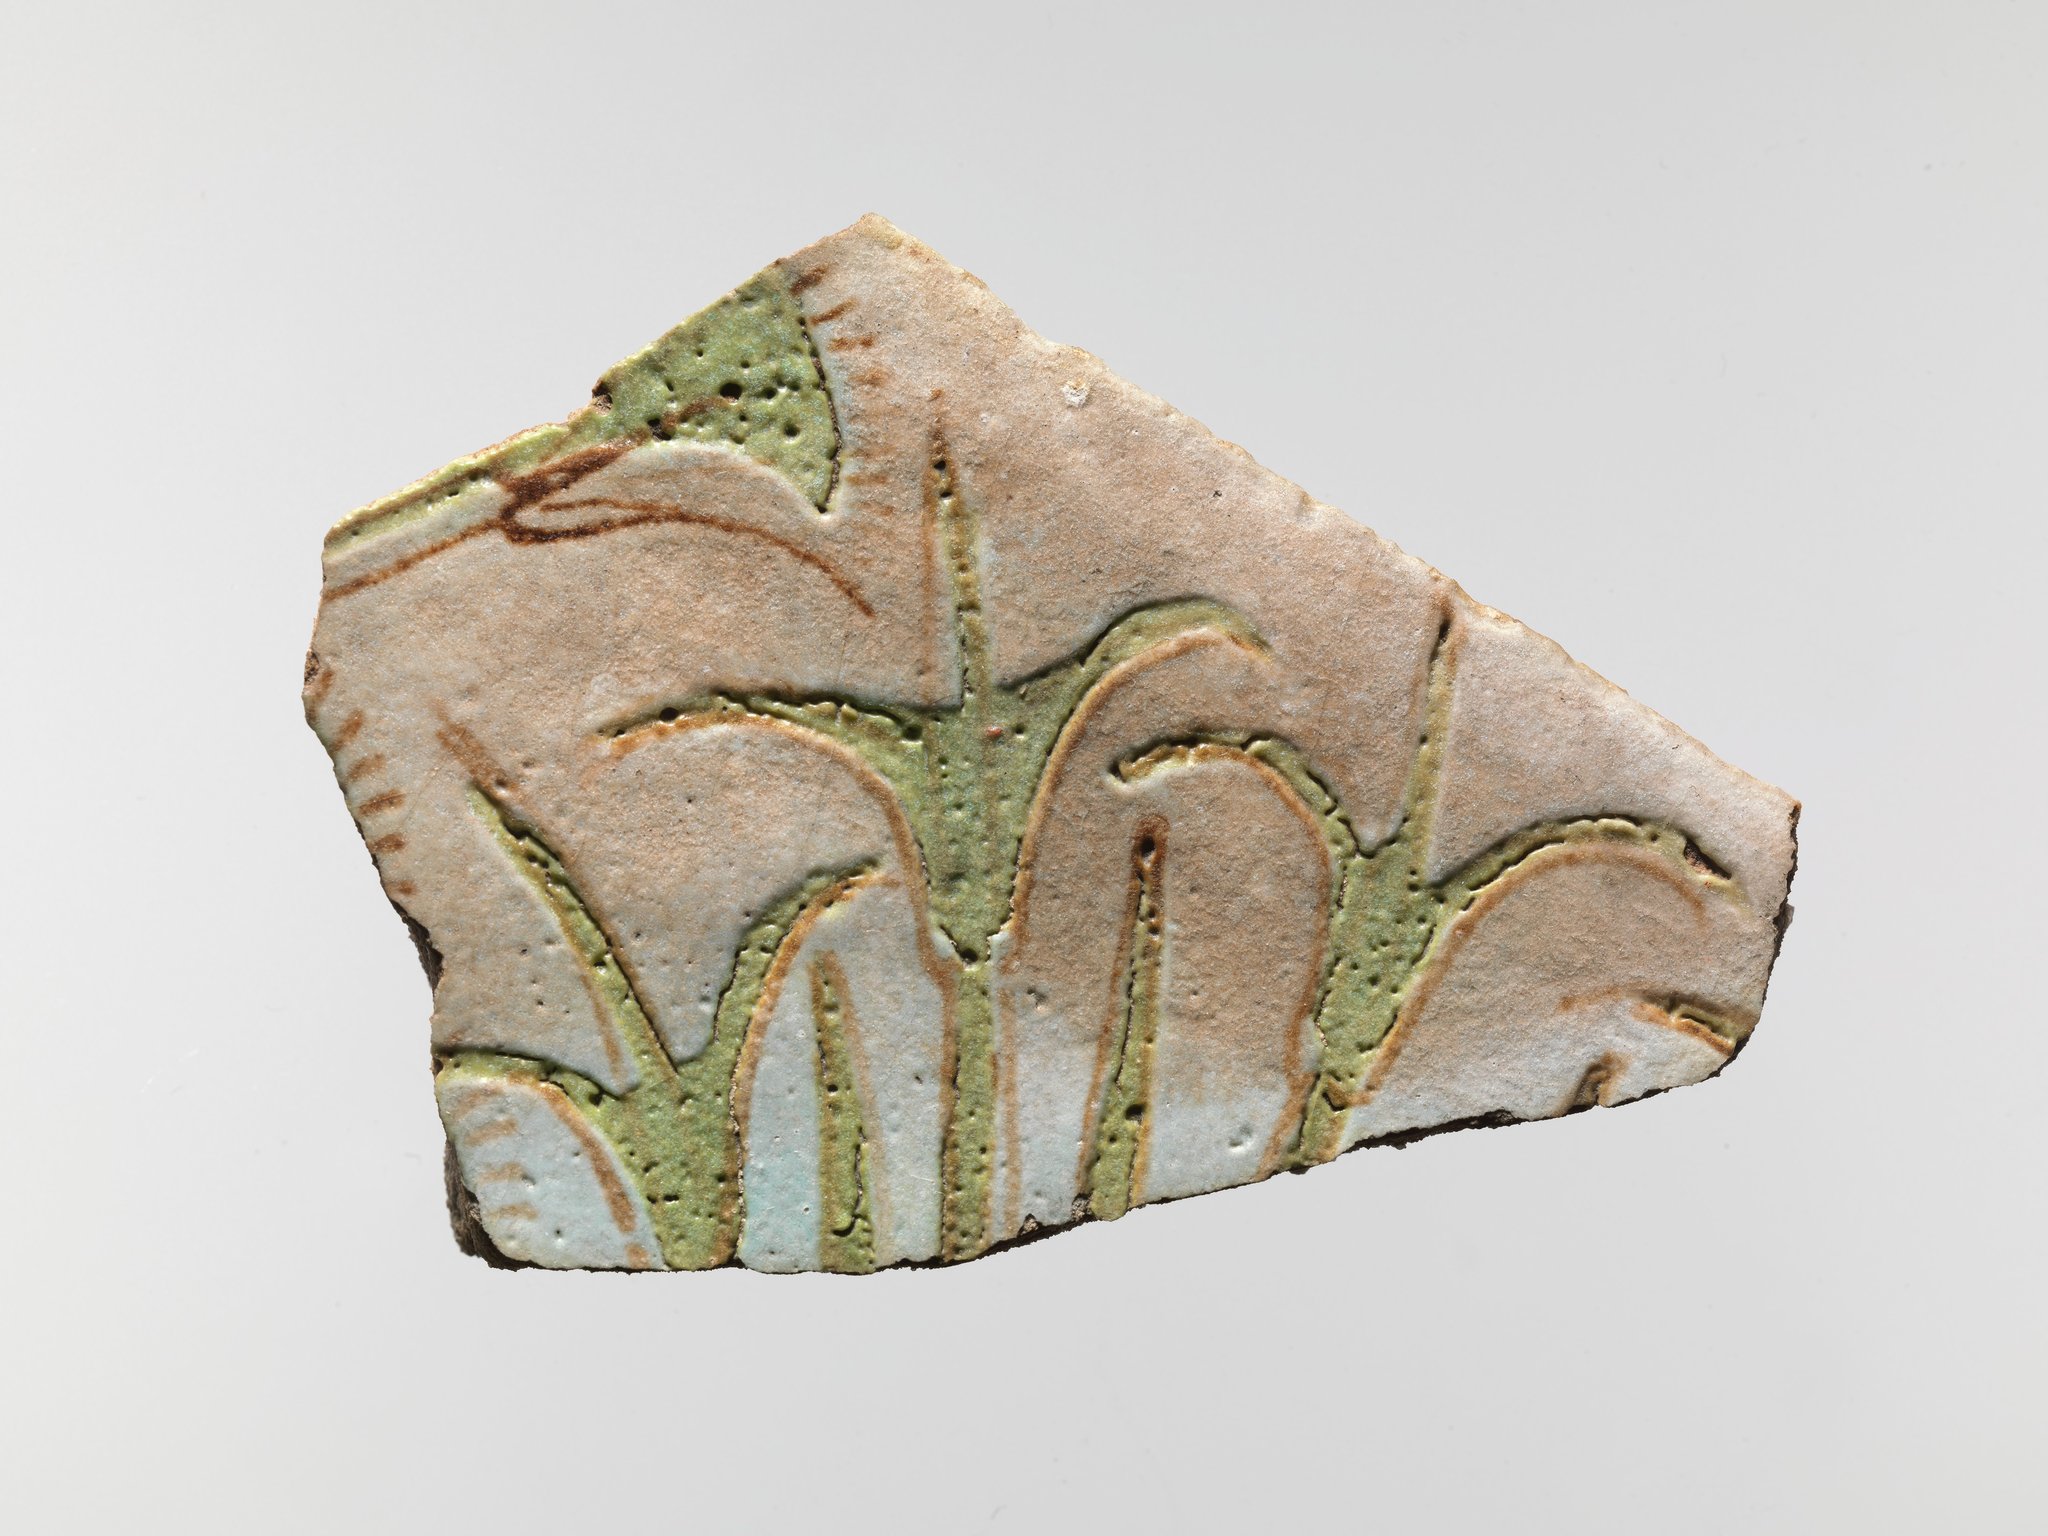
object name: tile fragment, marsh scene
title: Tile, marsh scene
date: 1353-1336 BCE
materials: faience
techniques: polychrome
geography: egypt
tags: plants